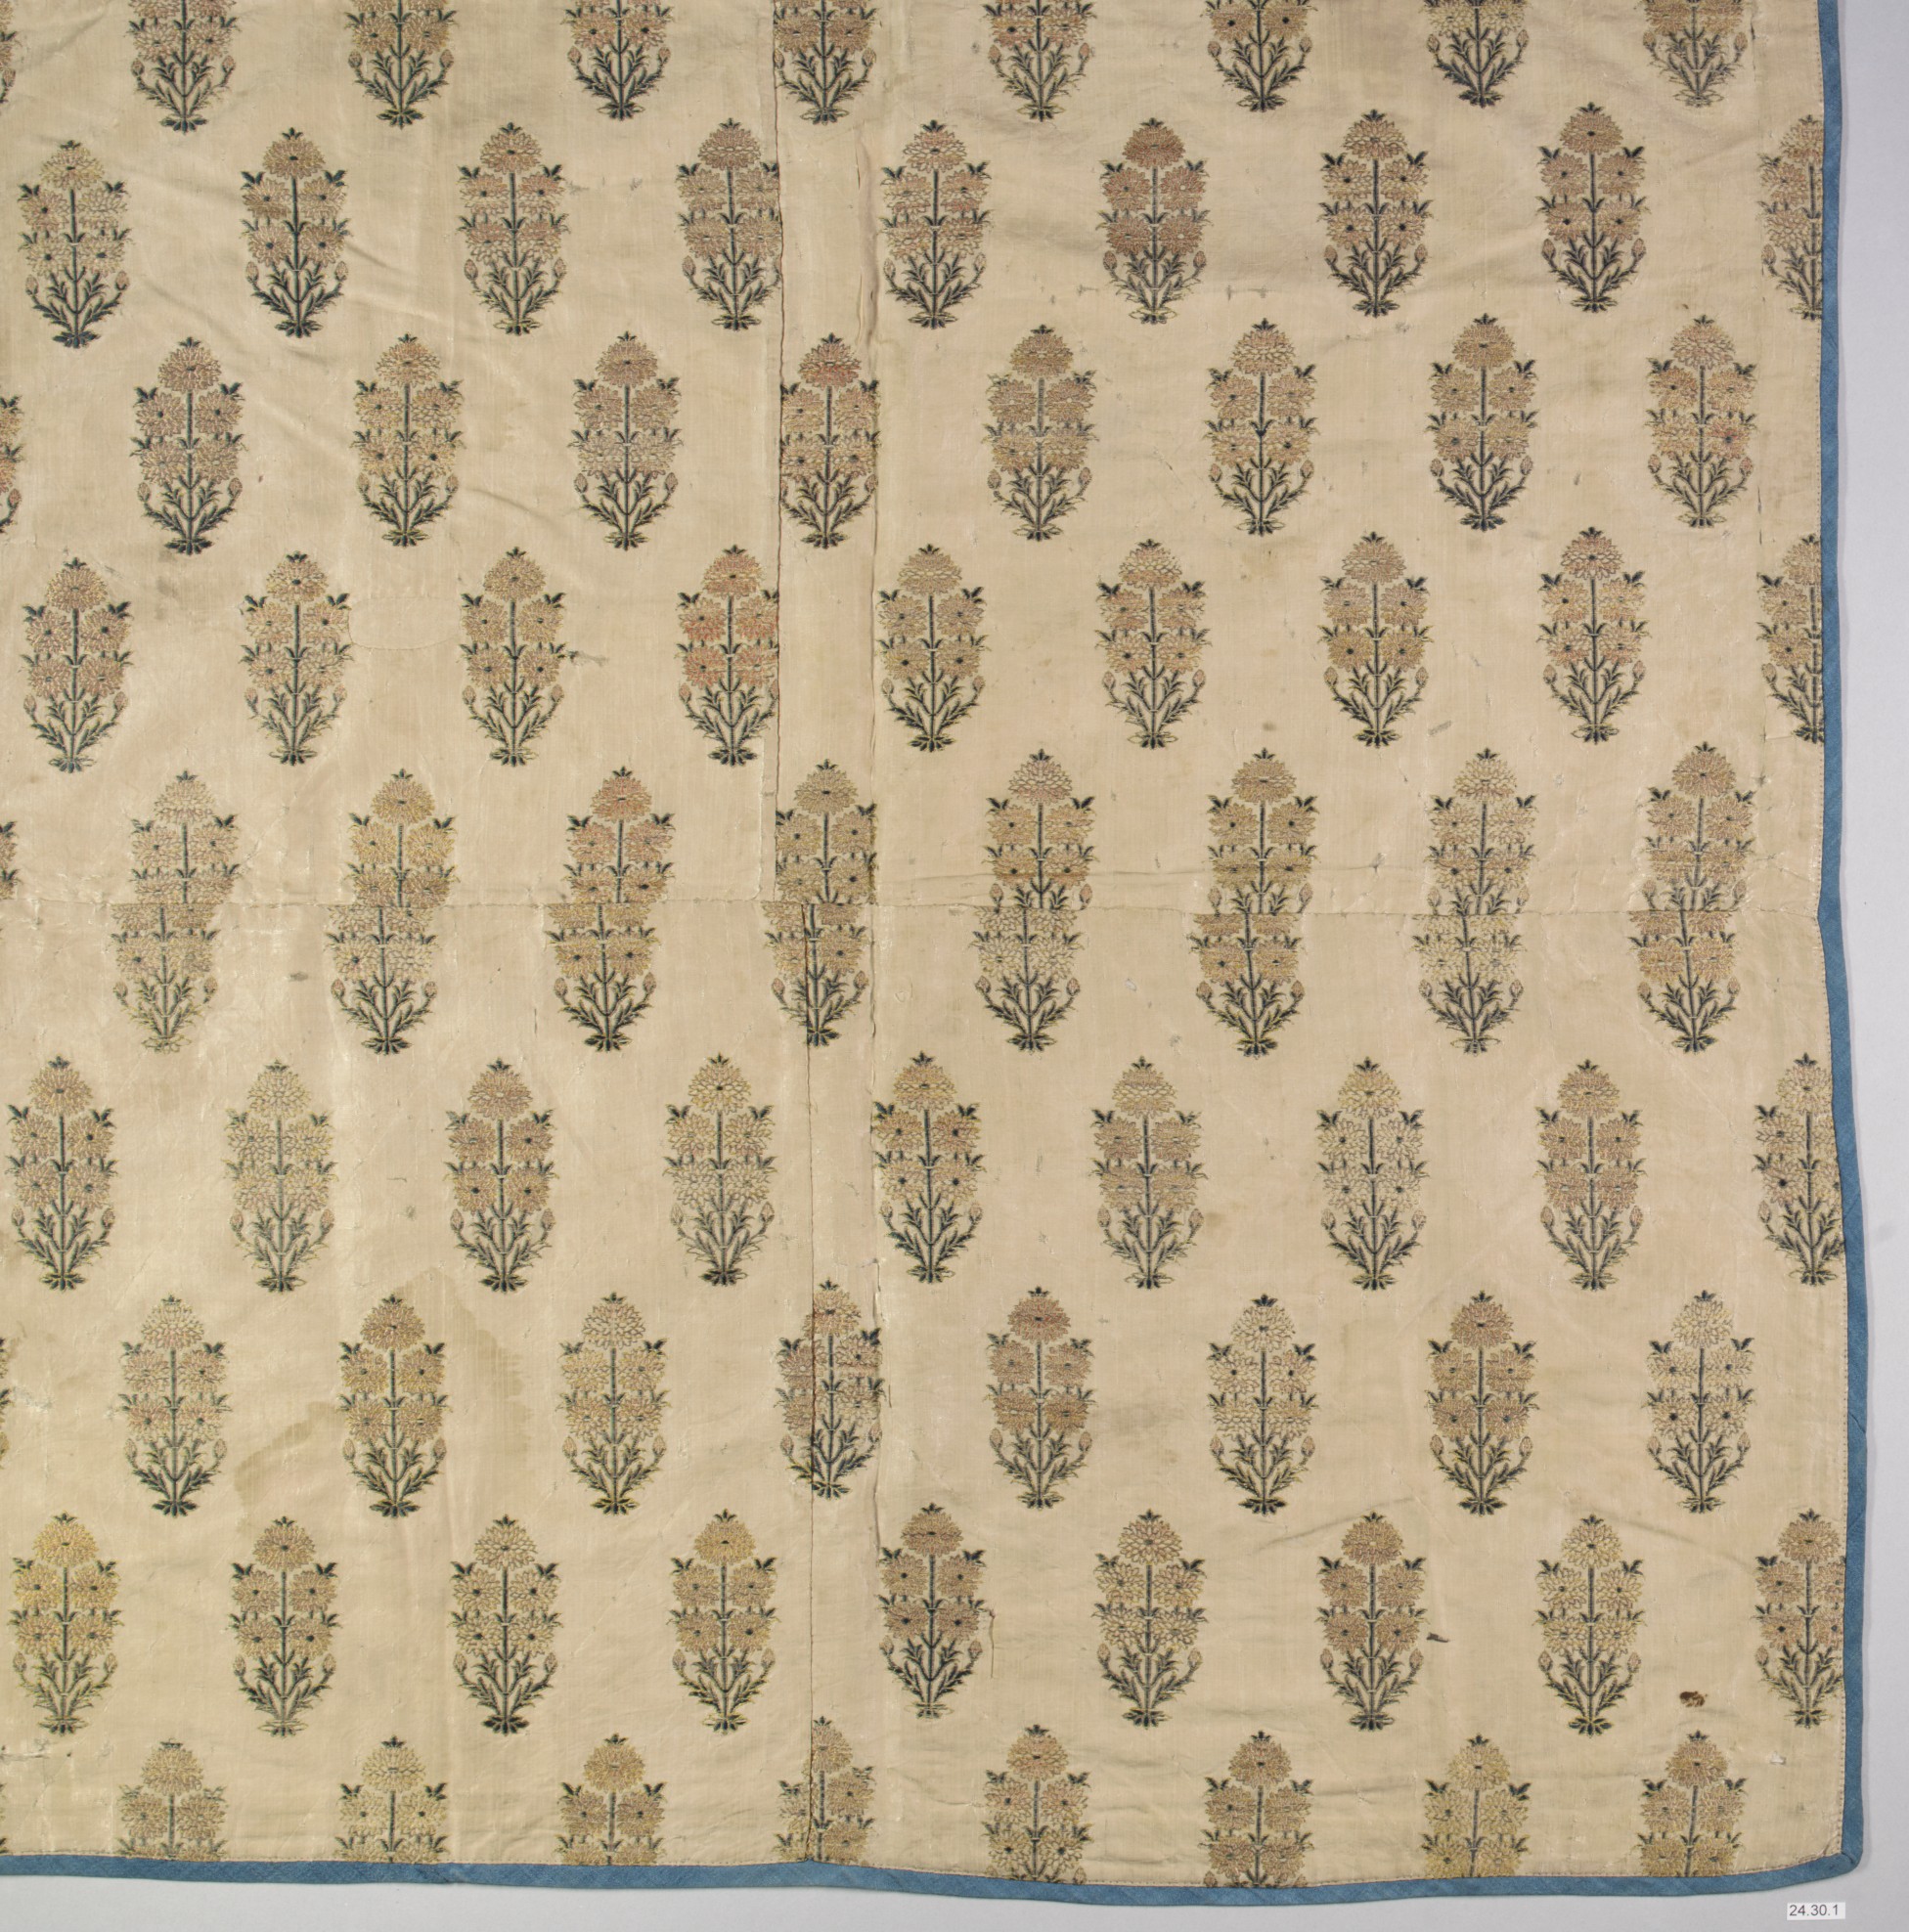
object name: brocade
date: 1701-1800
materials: cotton, metal thread, silk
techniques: brocade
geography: iran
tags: flowers